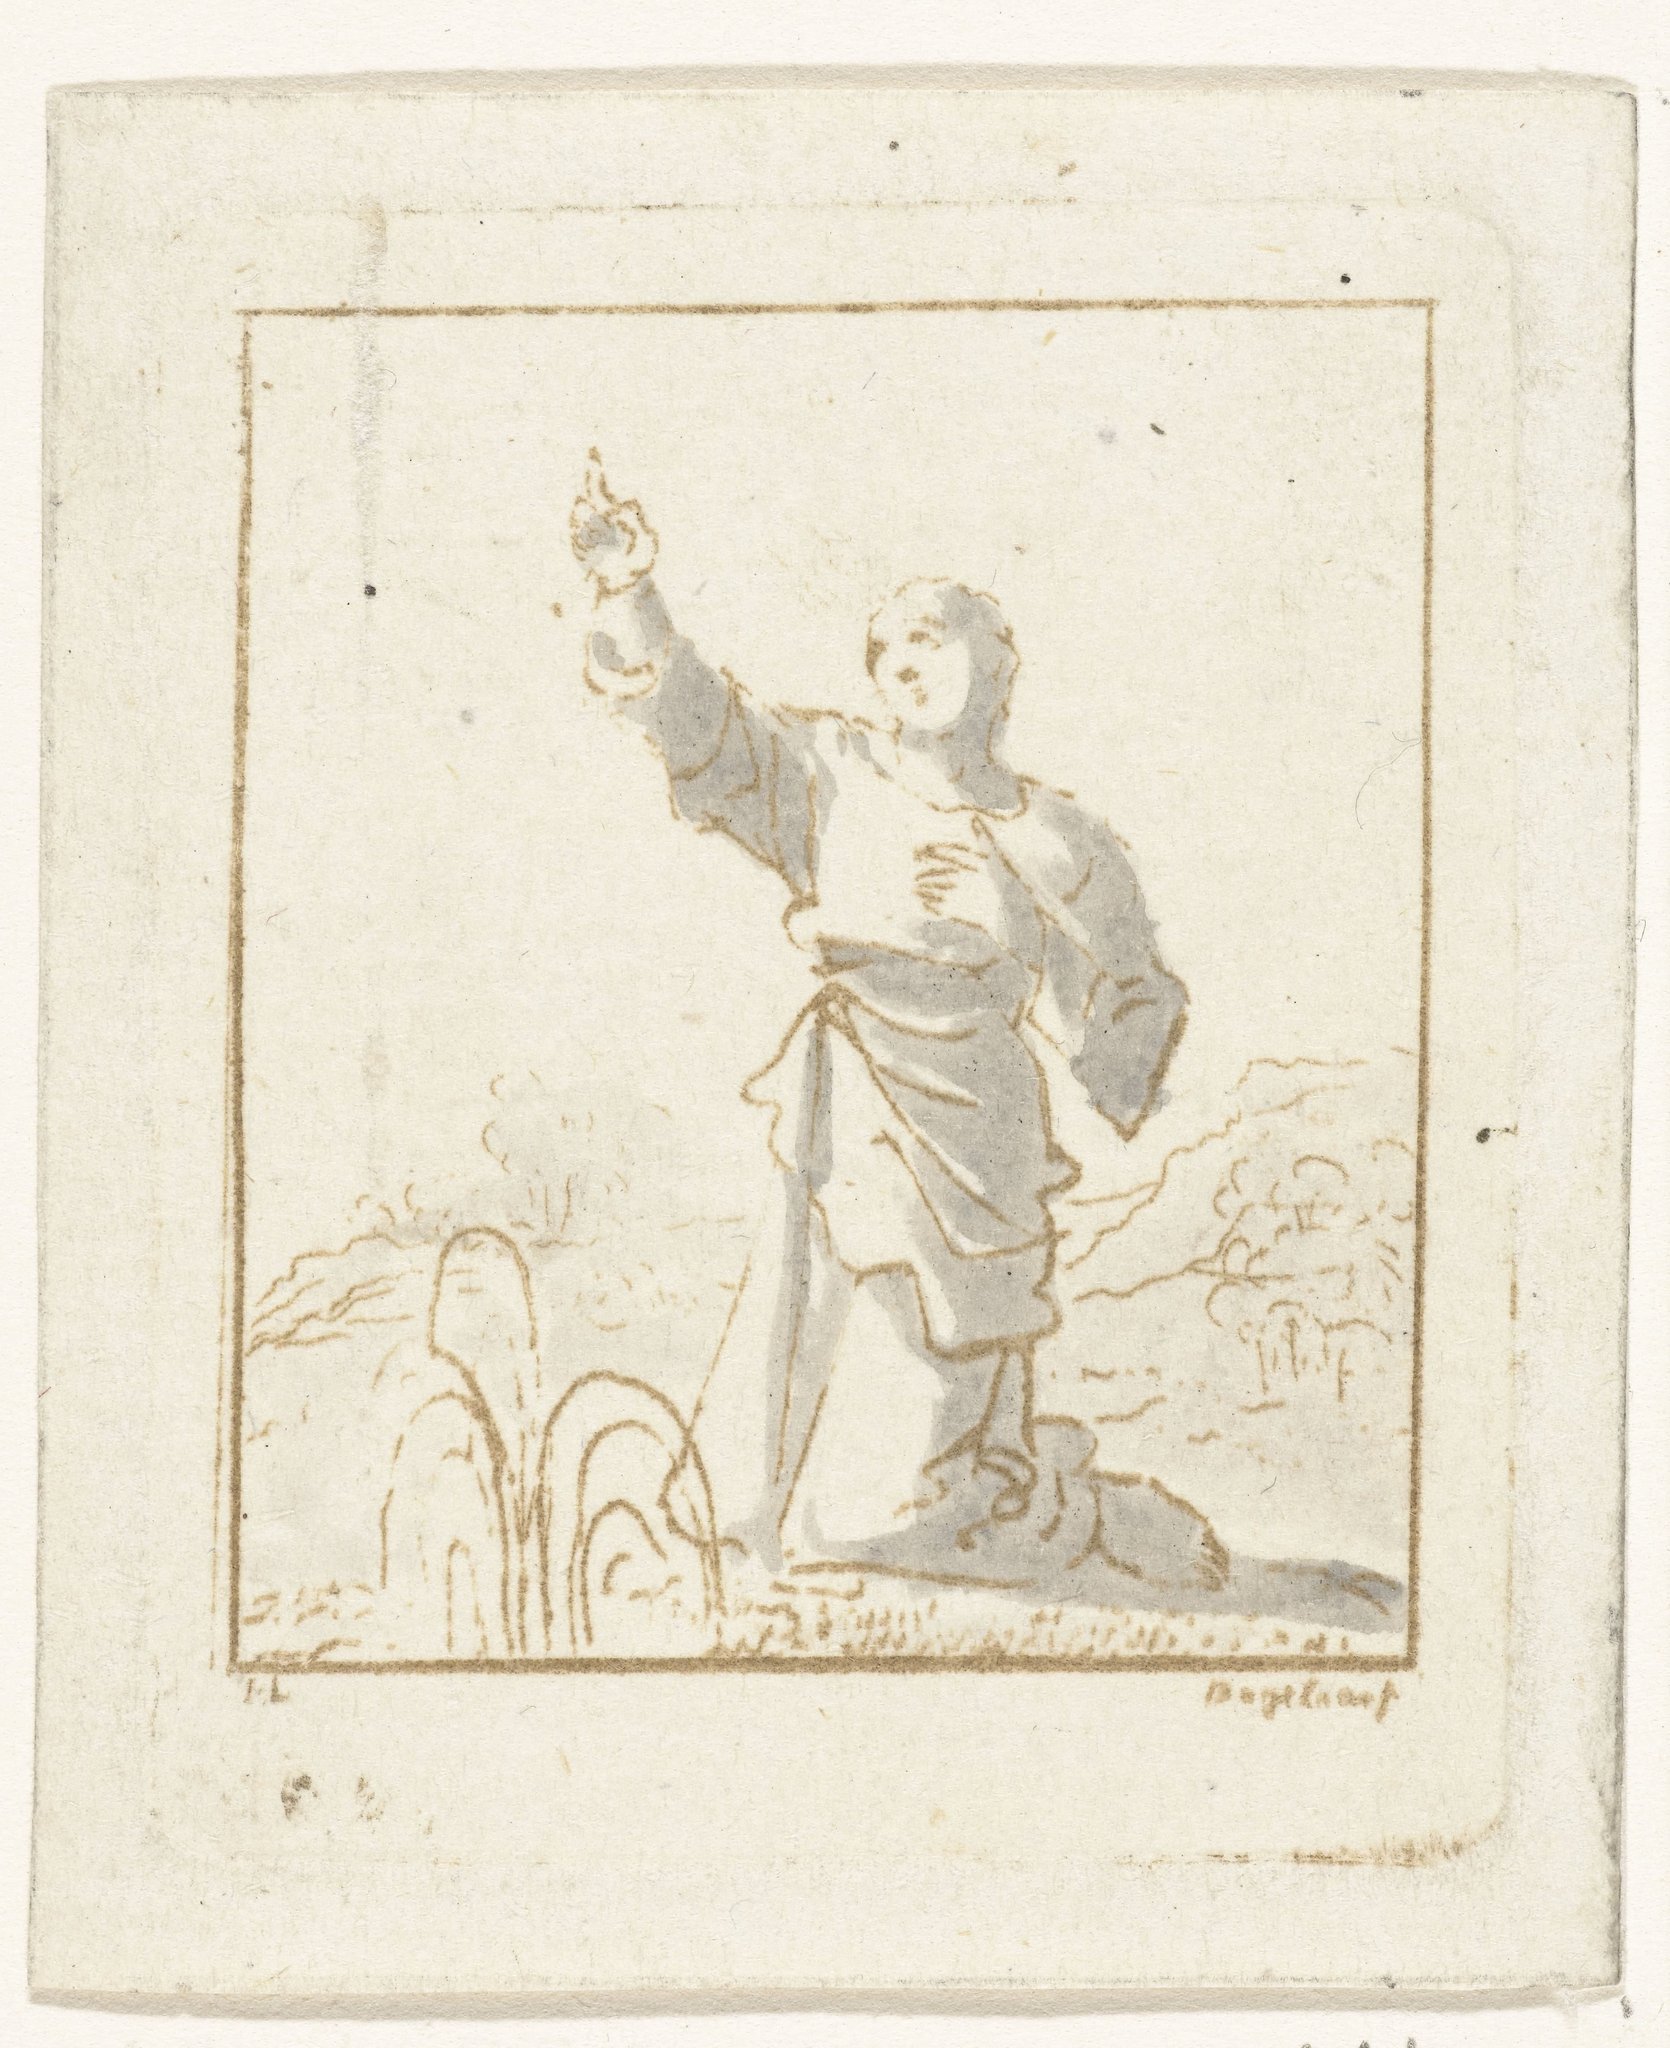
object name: print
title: De ziel wijst naar de sterrenhemel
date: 1798-1837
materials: ink, paper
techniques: brush, etching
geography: netherlands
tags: stars in the firmament, christ and the soul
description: Een knielende man, de personificatie van de ziel, wijst naar de sterrenhemel. Deze prent verbeeldt een detail van een tekening van Jan Luyken getiteld: Jezus en de ziel beschouwen de sterrenhemel.